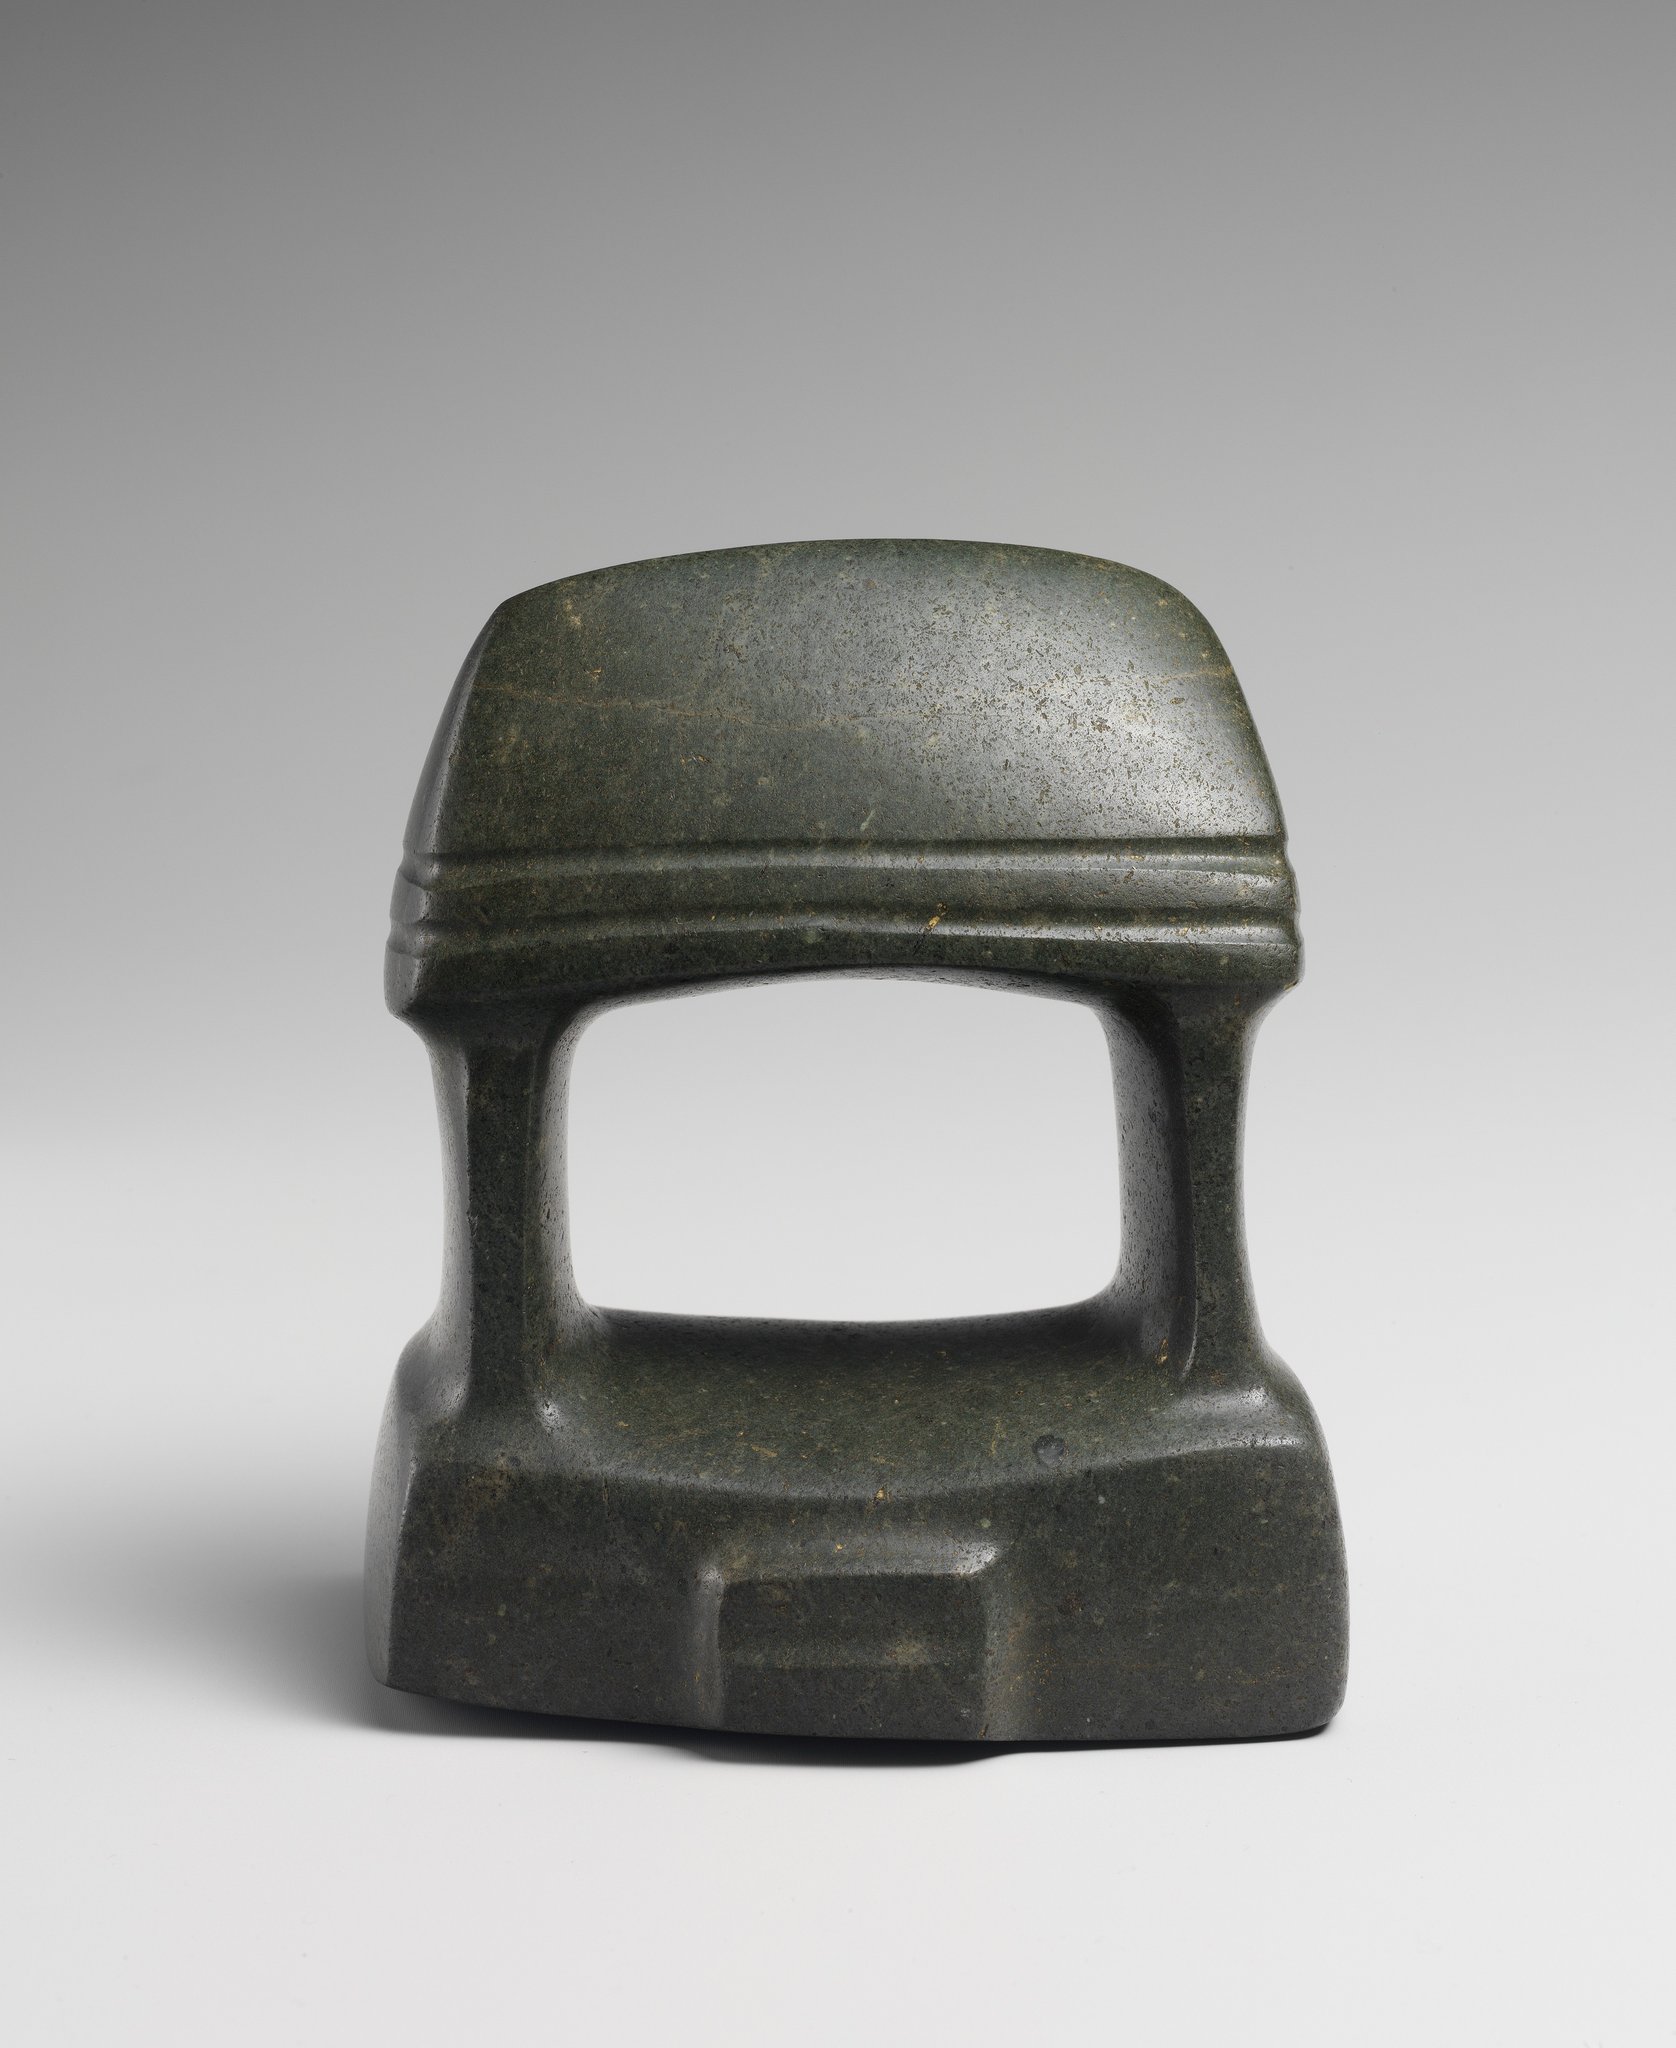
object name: architectural model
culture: mezcala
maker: mezcala artist(s)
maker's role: artist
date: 300 BCE-300 CE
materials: stone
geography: mexico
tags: temples